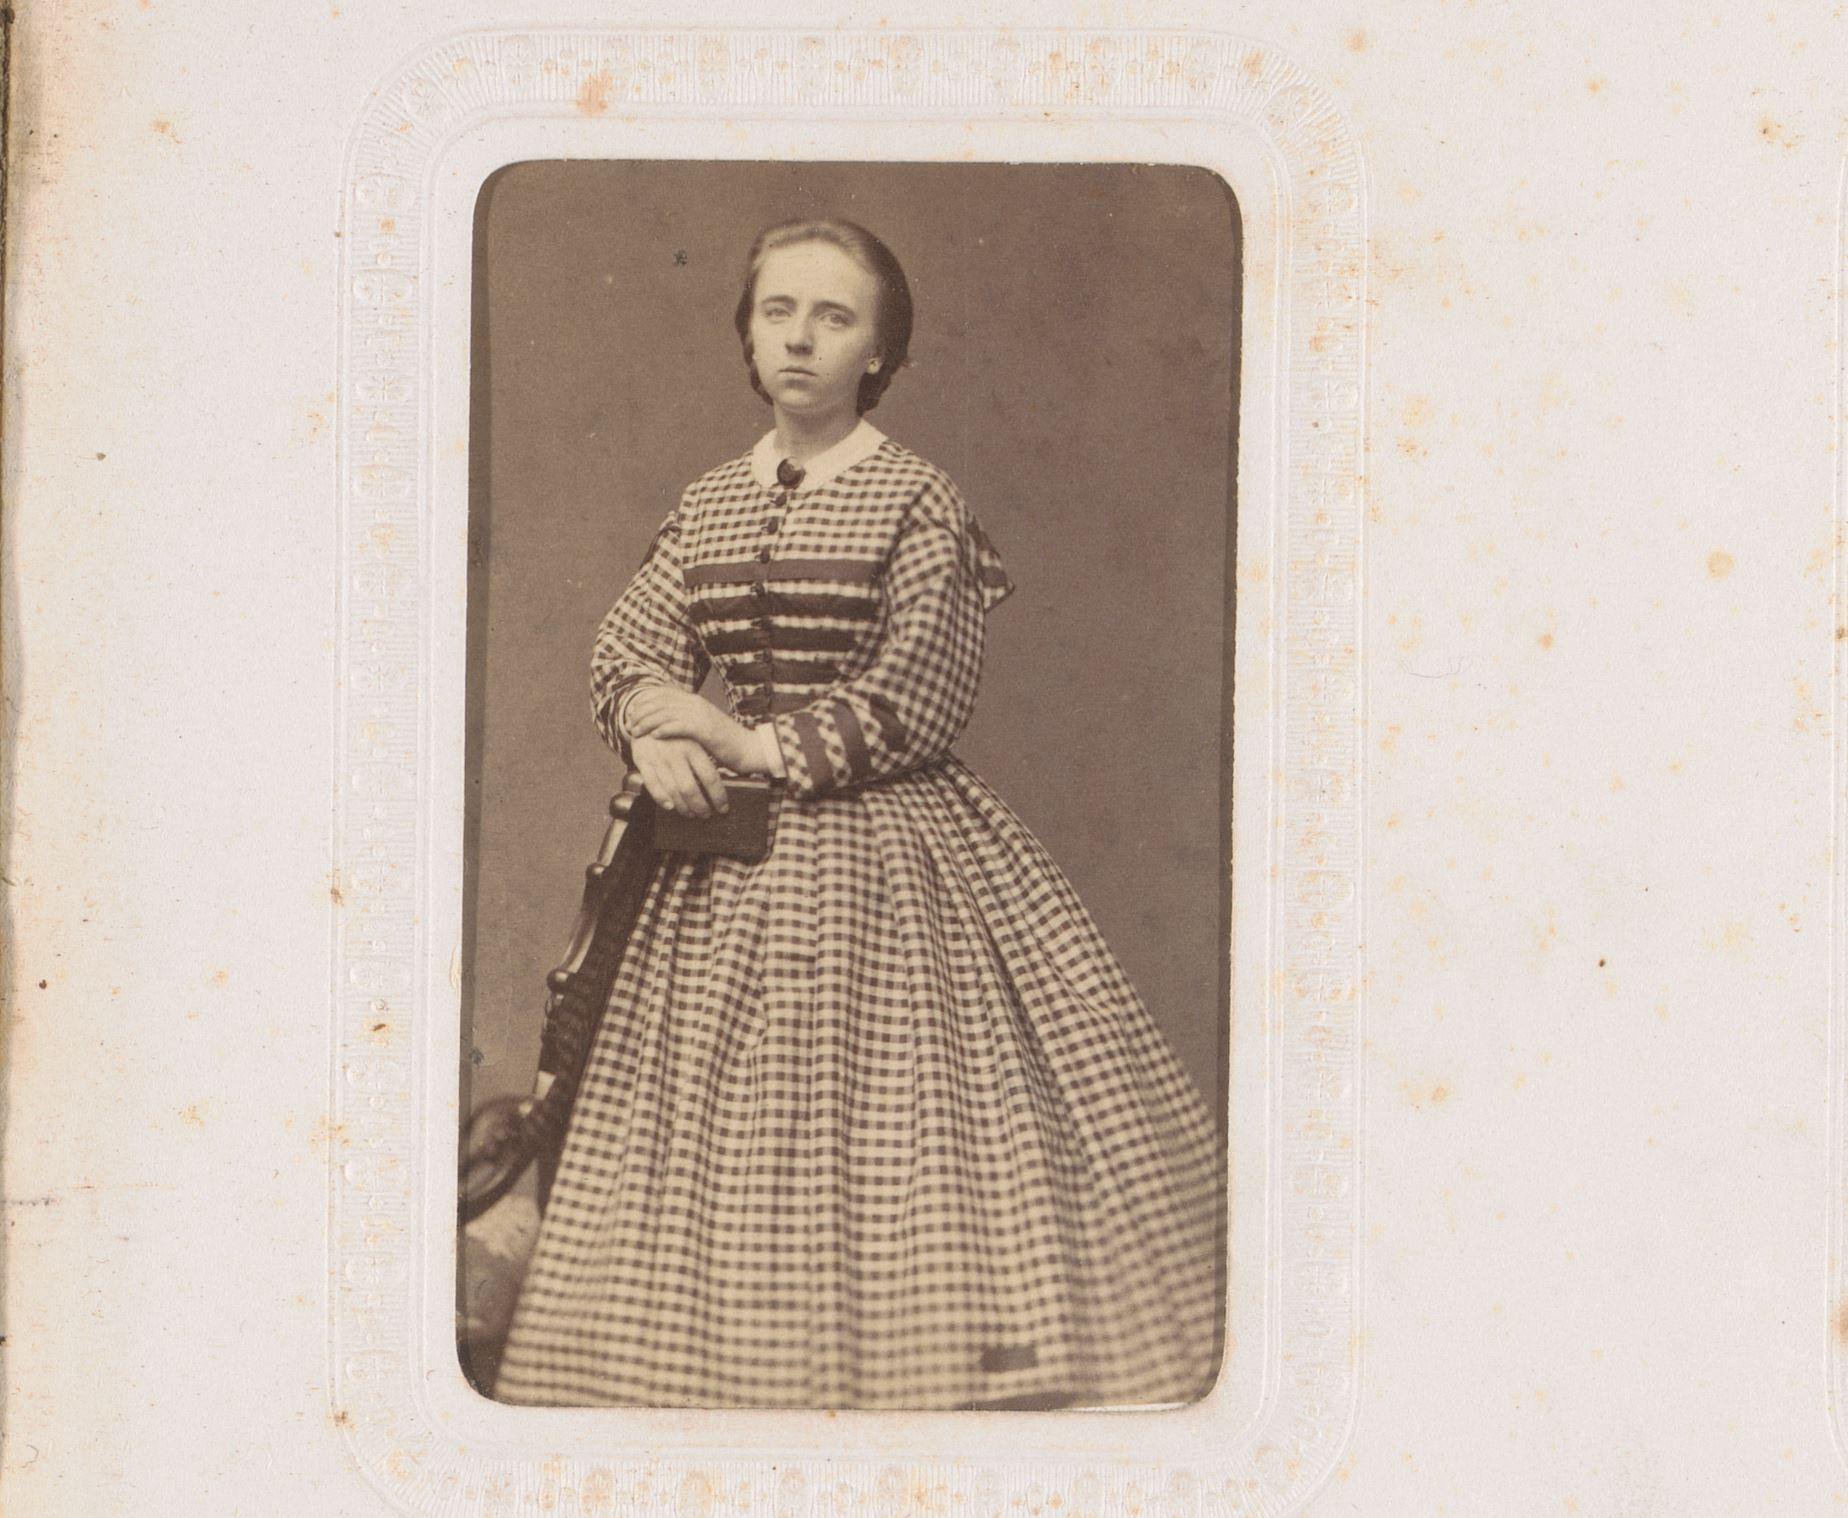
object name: album leaf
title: Portret van een meisje in geblokte jurk, staand bij een stoel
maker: Anonymous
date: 1860-1880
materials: cardboard, photographic support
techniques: albumen print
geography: netherlands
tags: historical persons - bb - woman, girl (child between toddler and youth), chair